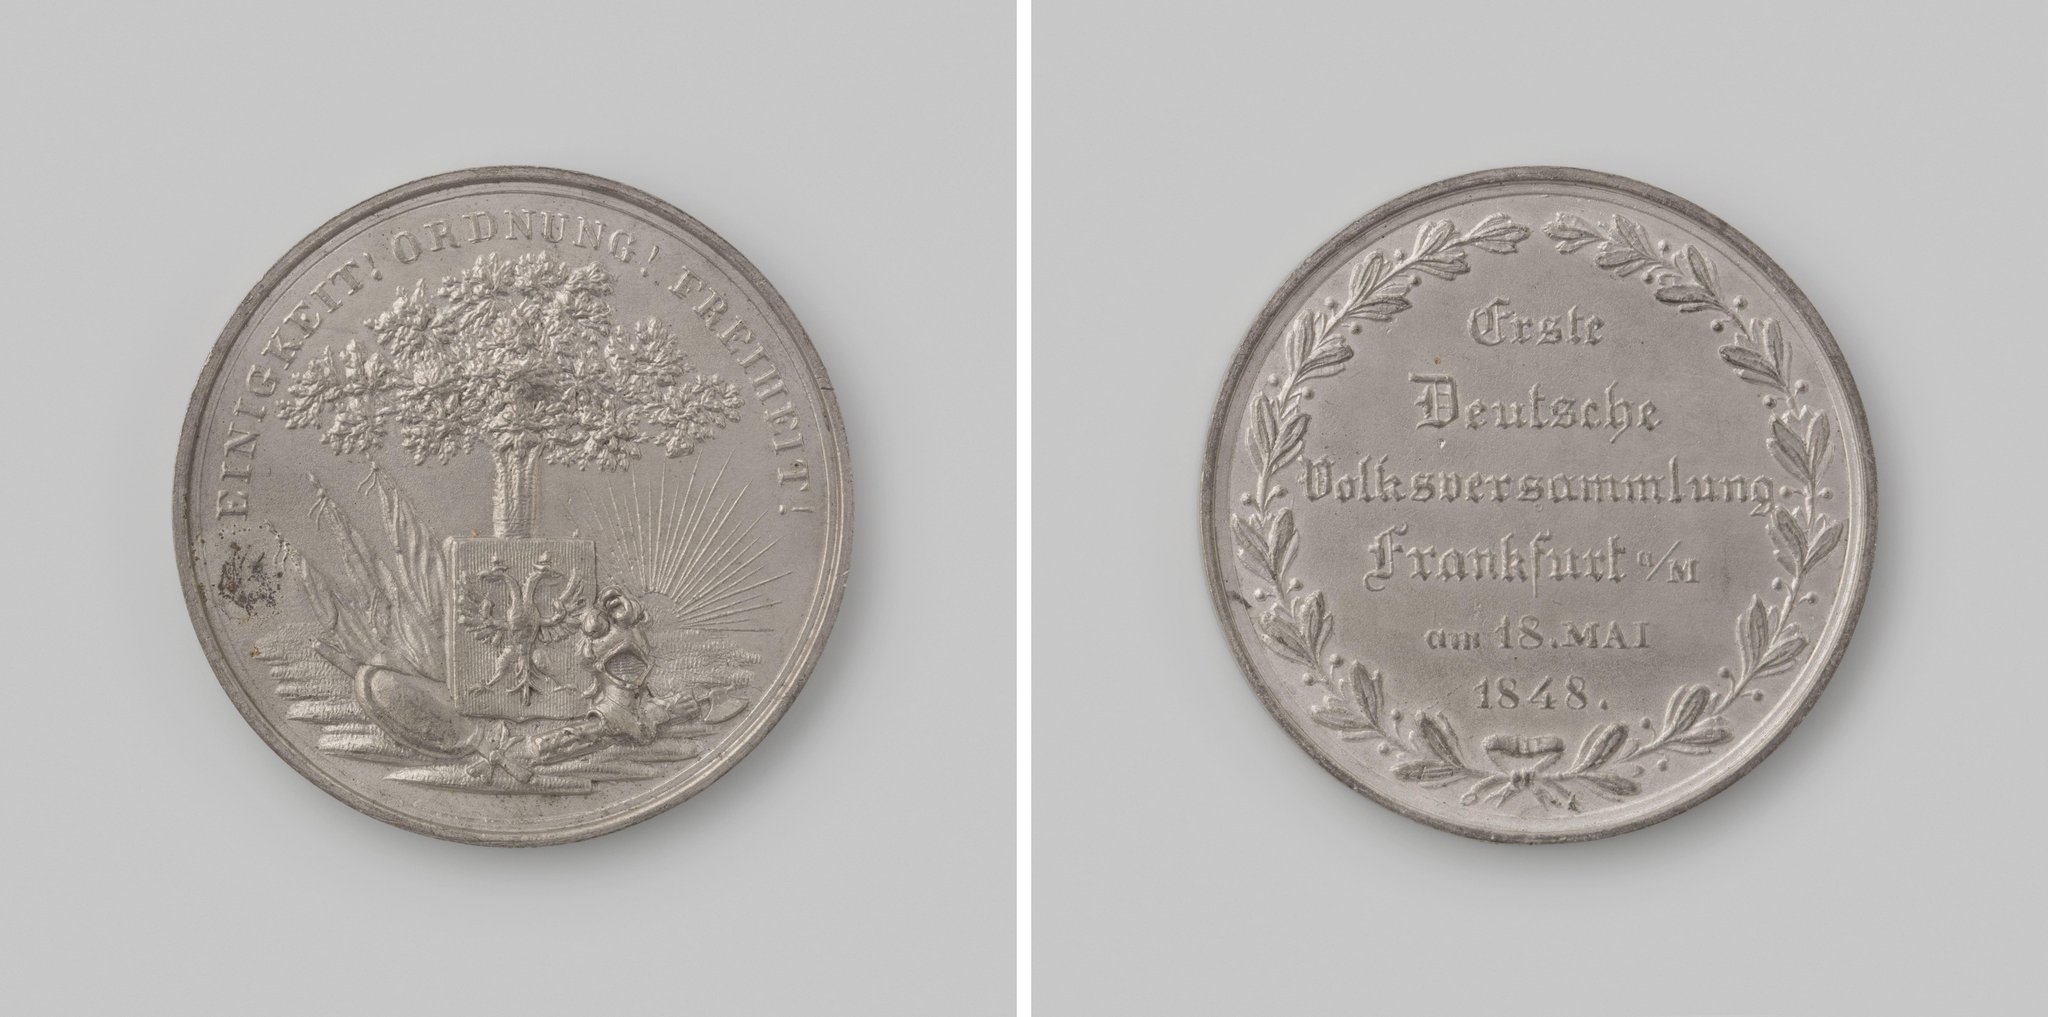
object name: history medal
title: Eerste Duitse Nationale Vergadering te Frankfurt 1848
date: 1848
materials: tin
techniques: casting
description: Tinnen penning, op de voorzijde een boom waartegen een wapenschild, vlaggen , wapens en een gehelmde fasces onder een opkomende zon, met omschrift, op de keerzijde zes regels tekst tussen samengestrikte lauwertakken.